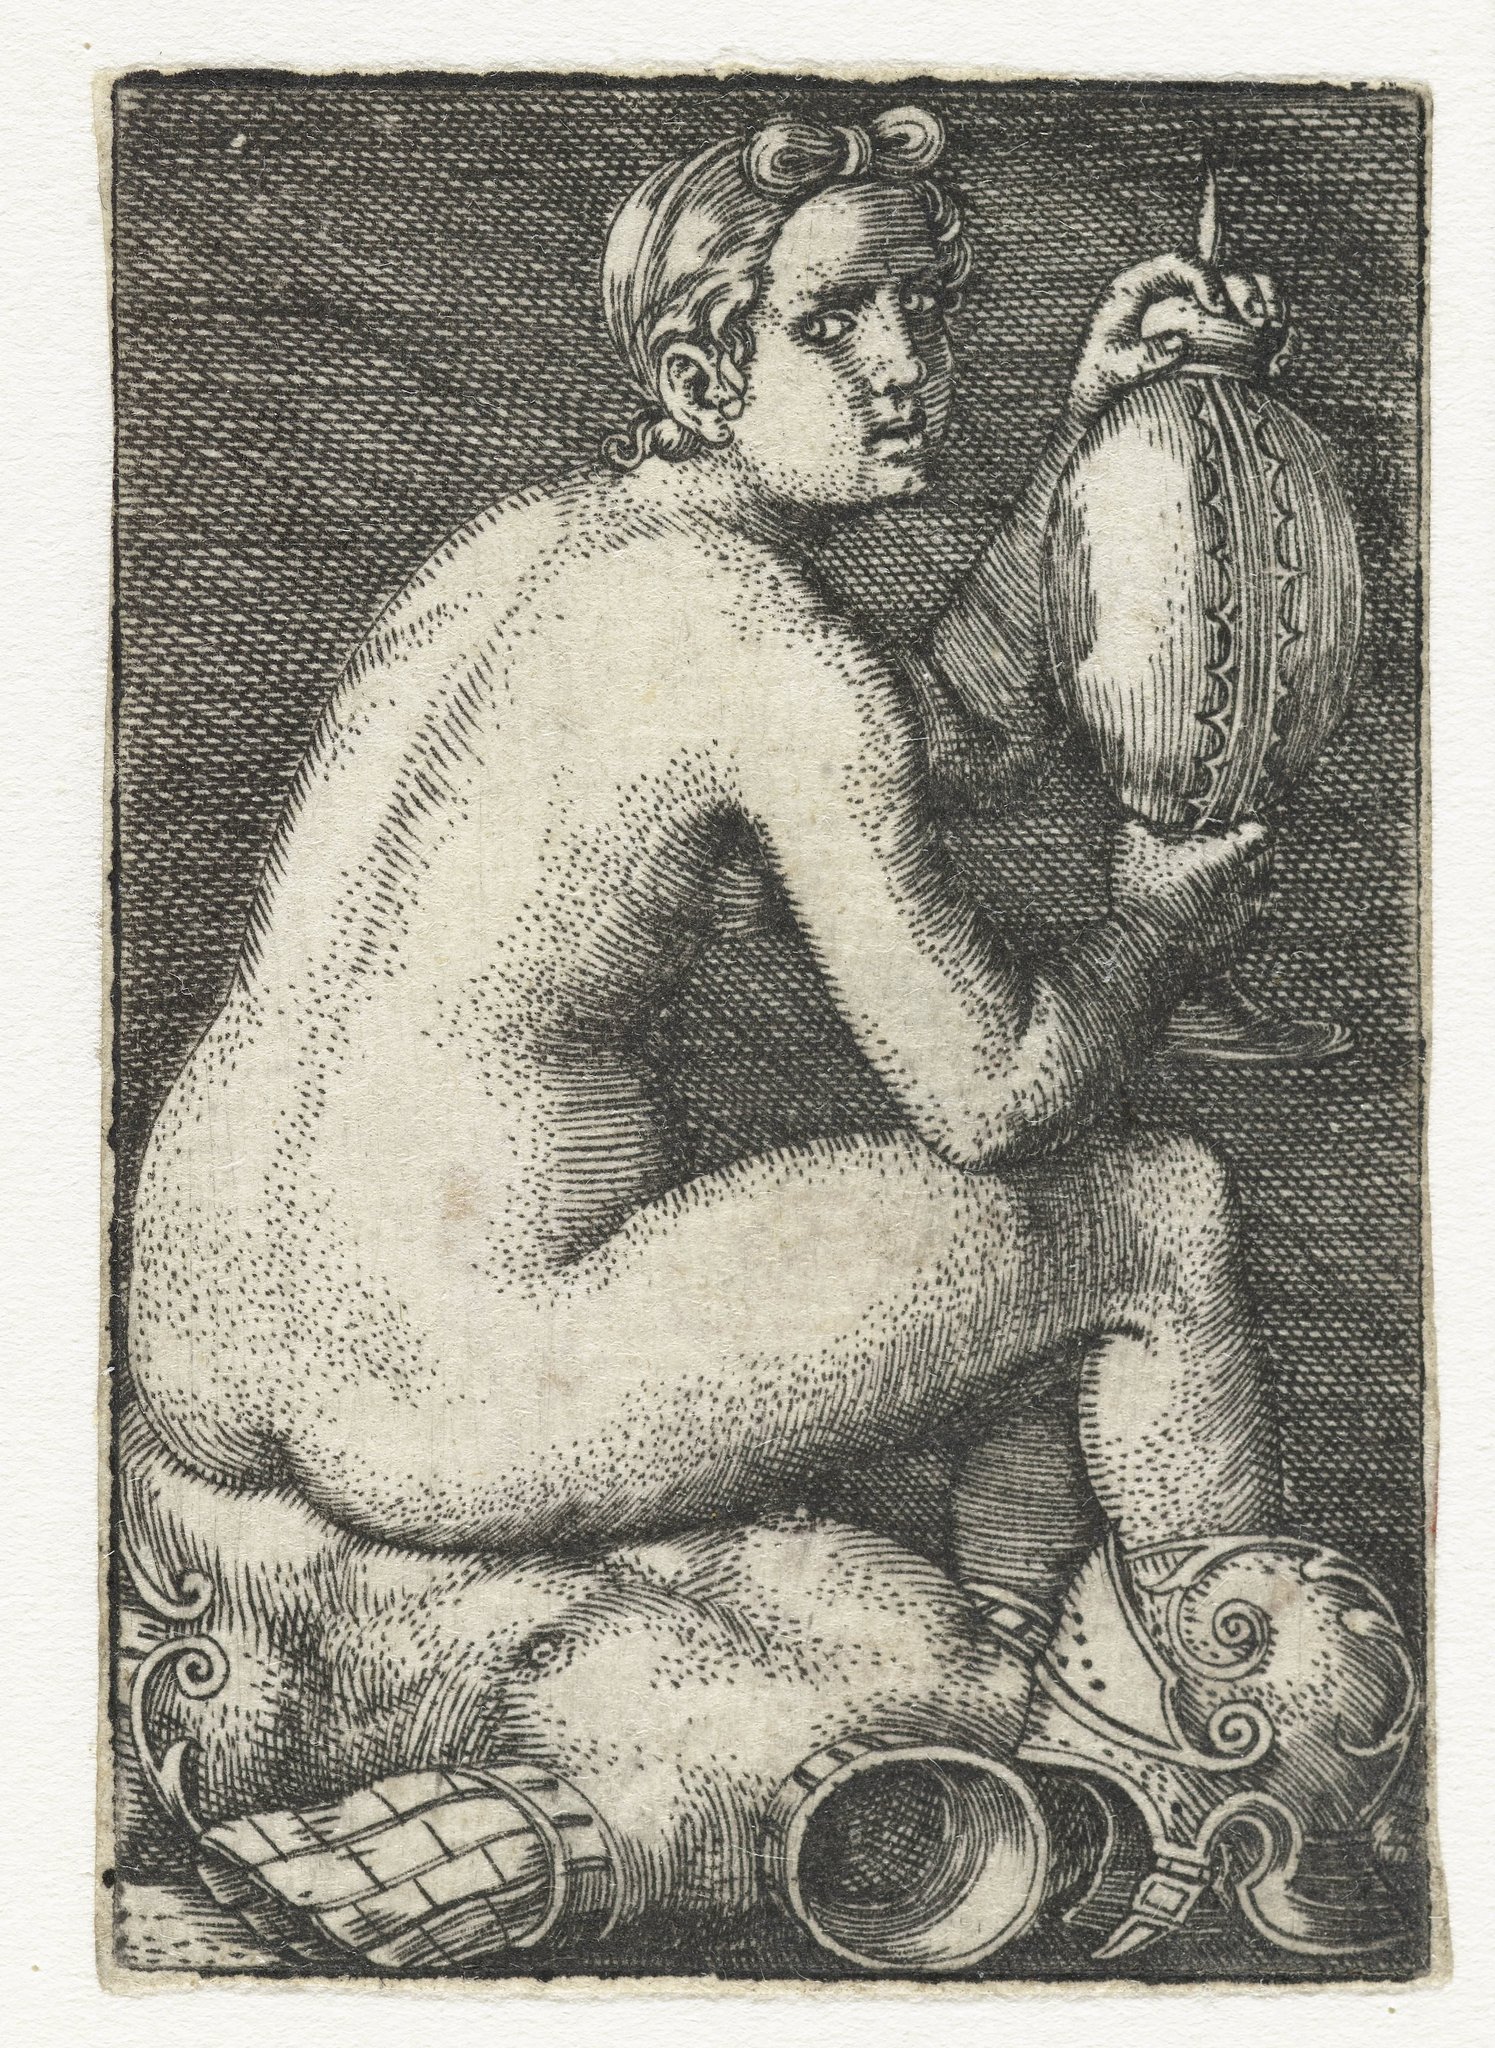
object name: print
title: Naakte vrouw zittend op wapenrusting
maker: barthel beham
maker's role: print maker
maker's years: 1502-1540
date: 1512-1540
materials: paper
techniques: engraving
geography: germany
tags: the (nude) human figure; 'corpo humano' (ripa), female sex; woman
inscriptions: collector's mark: Lugt 240